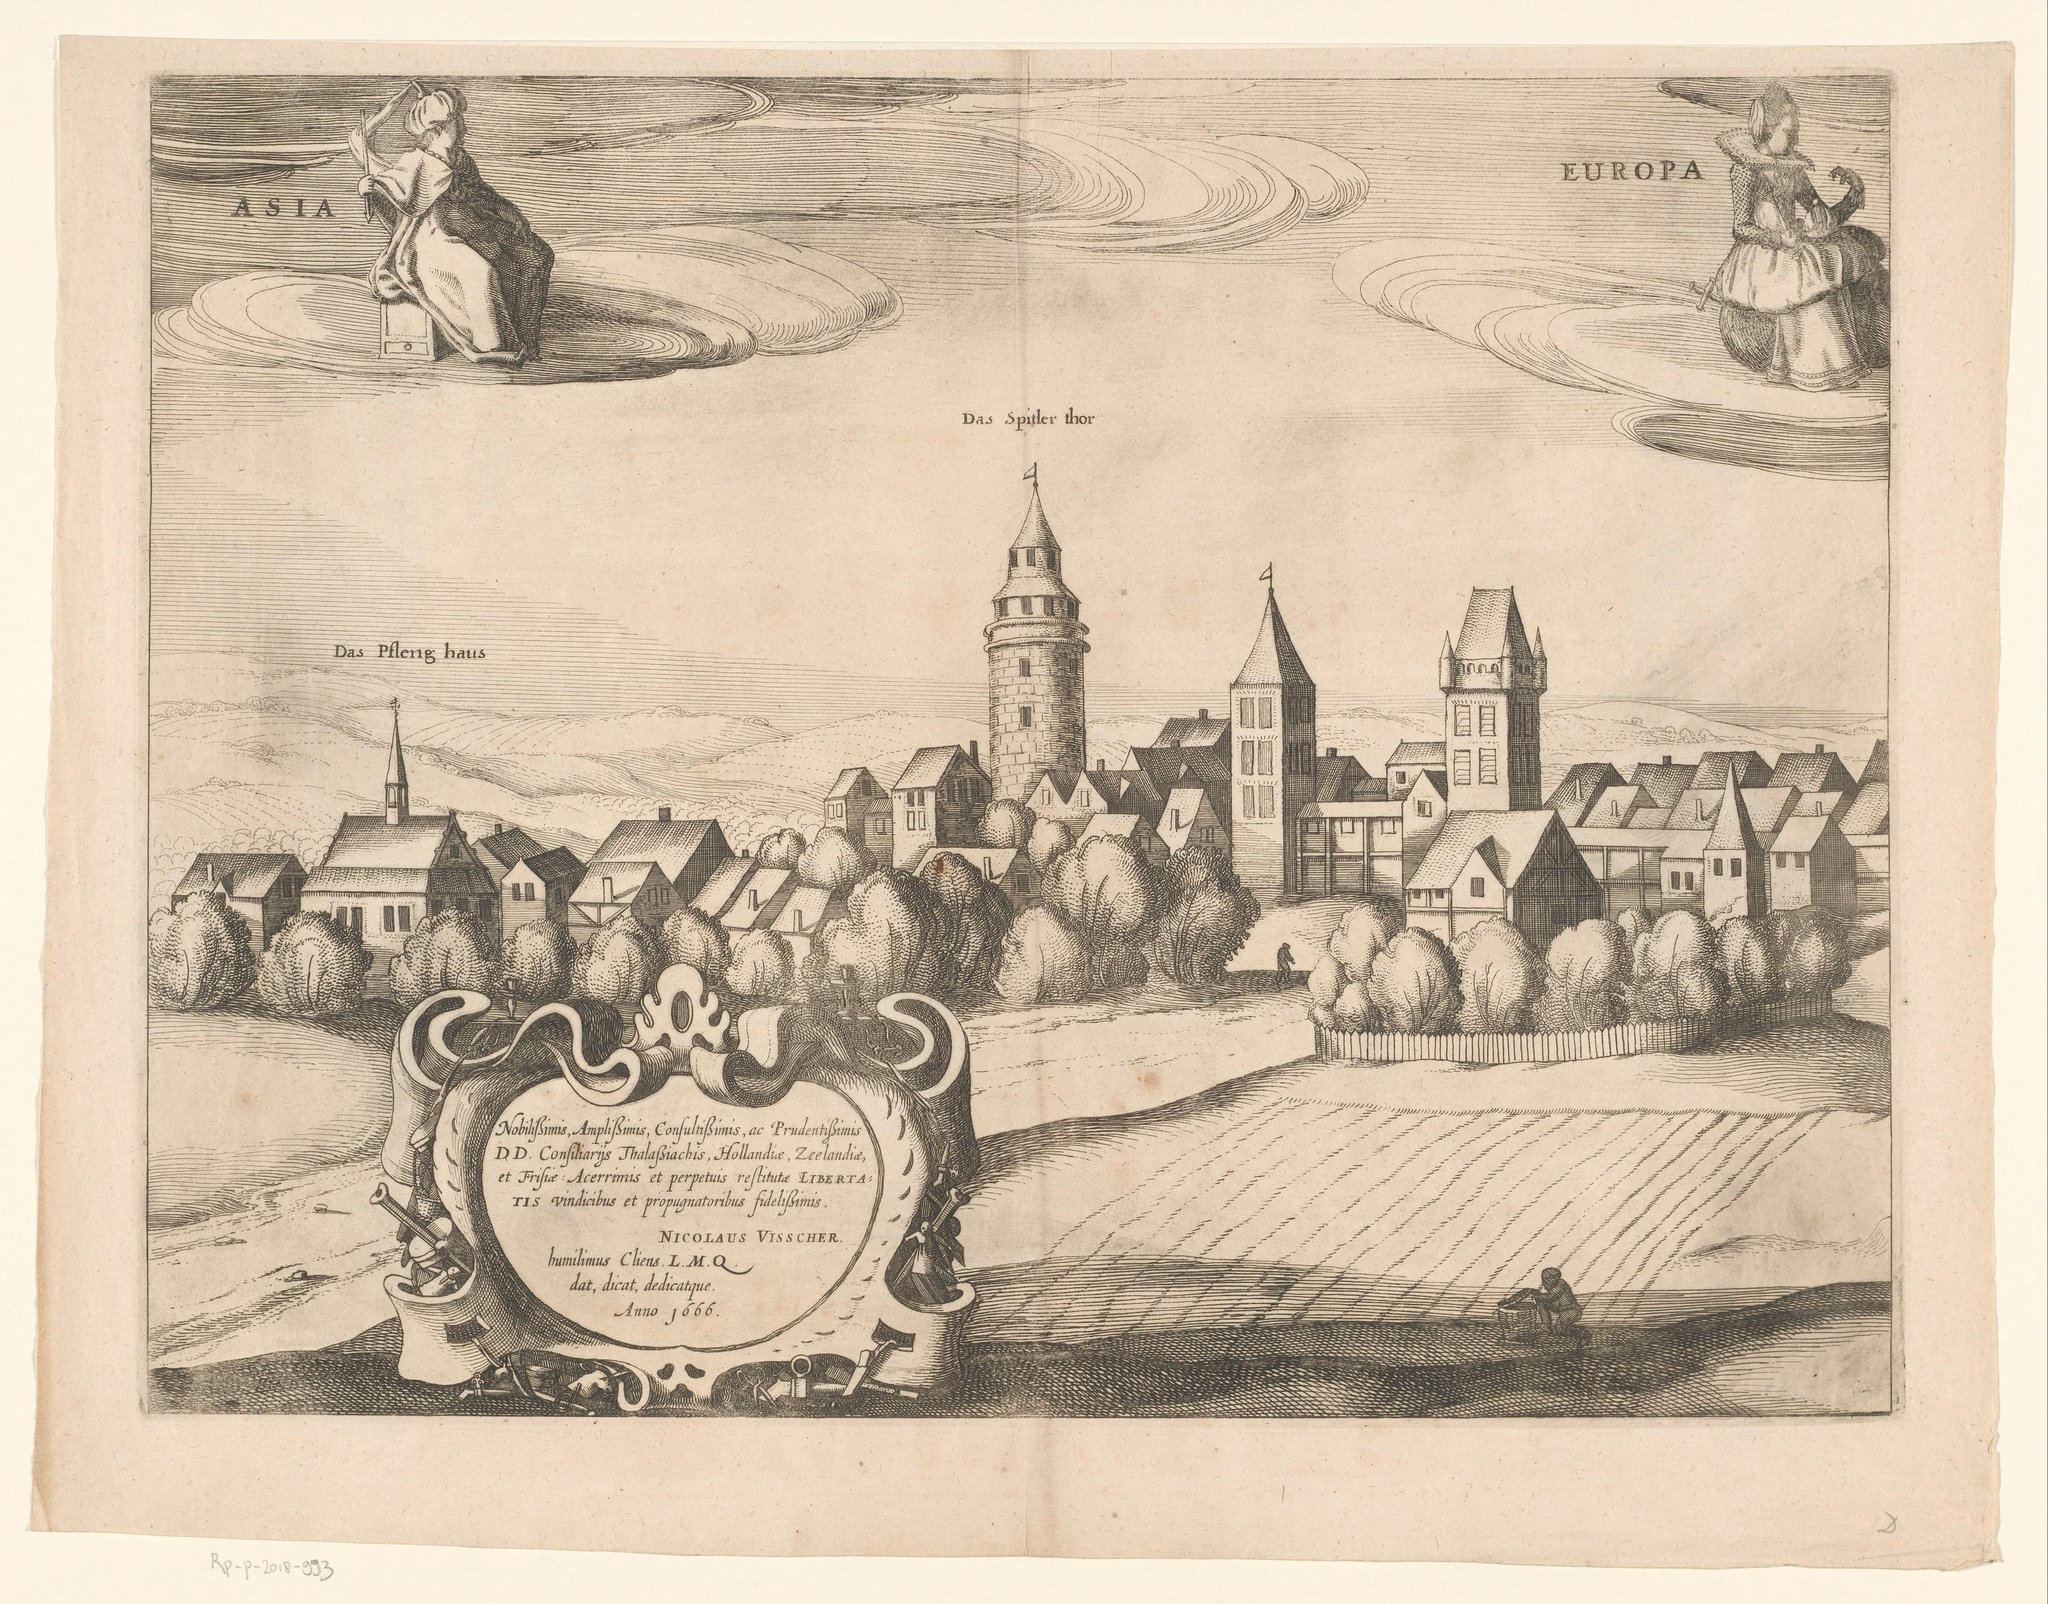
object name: print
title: Gezicht op Neurenberg (blad 1)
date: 1666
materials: paper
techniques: etching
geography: amsterdam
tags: city-view, and landscape with man-made constructions, europe represented allegorically; 'europa' (ripa), asia represented allegorically; 'asia' (ripa)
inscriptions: collector's mark: Lugt 2228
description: Gezicht op de Duitse stad Neurenberg. In de lucht boven de stad zetelen de personificaties van Azië en Europa.